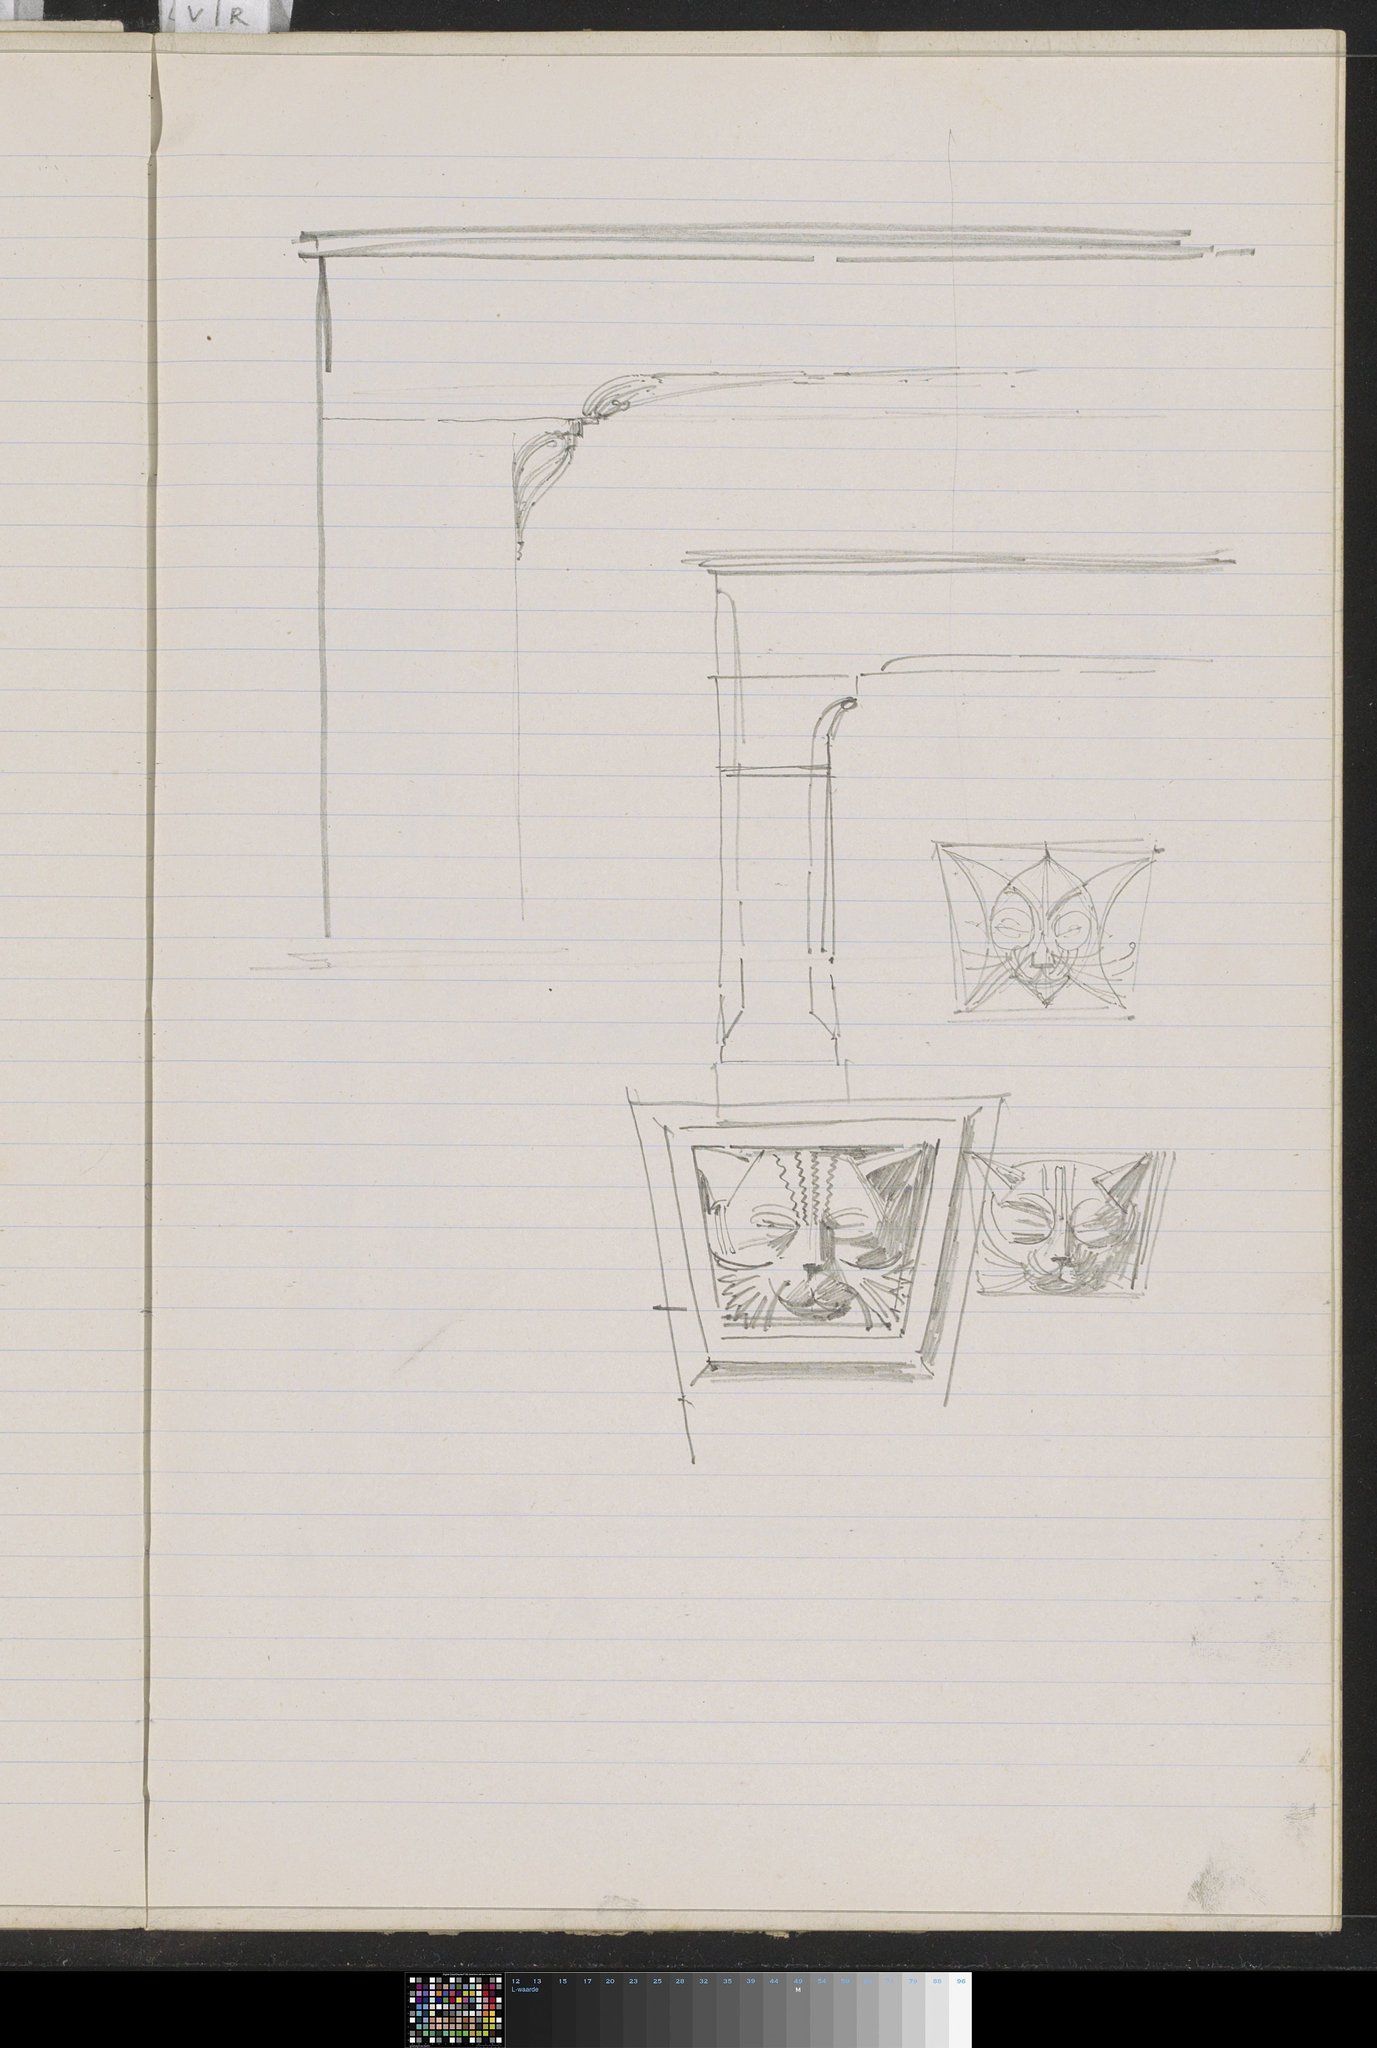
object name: sketchbook leaf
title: Triomfbogen en ornamenten met een kop van een kat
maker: gerrit willem dijsselhof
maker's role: designer, draughtsman, print maker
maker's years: 1866-1924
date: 1901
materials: pencil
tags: ornament derived from animal forms, triumphal arch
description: Blad 44 recto uit een schetsboek met 79 bladen.